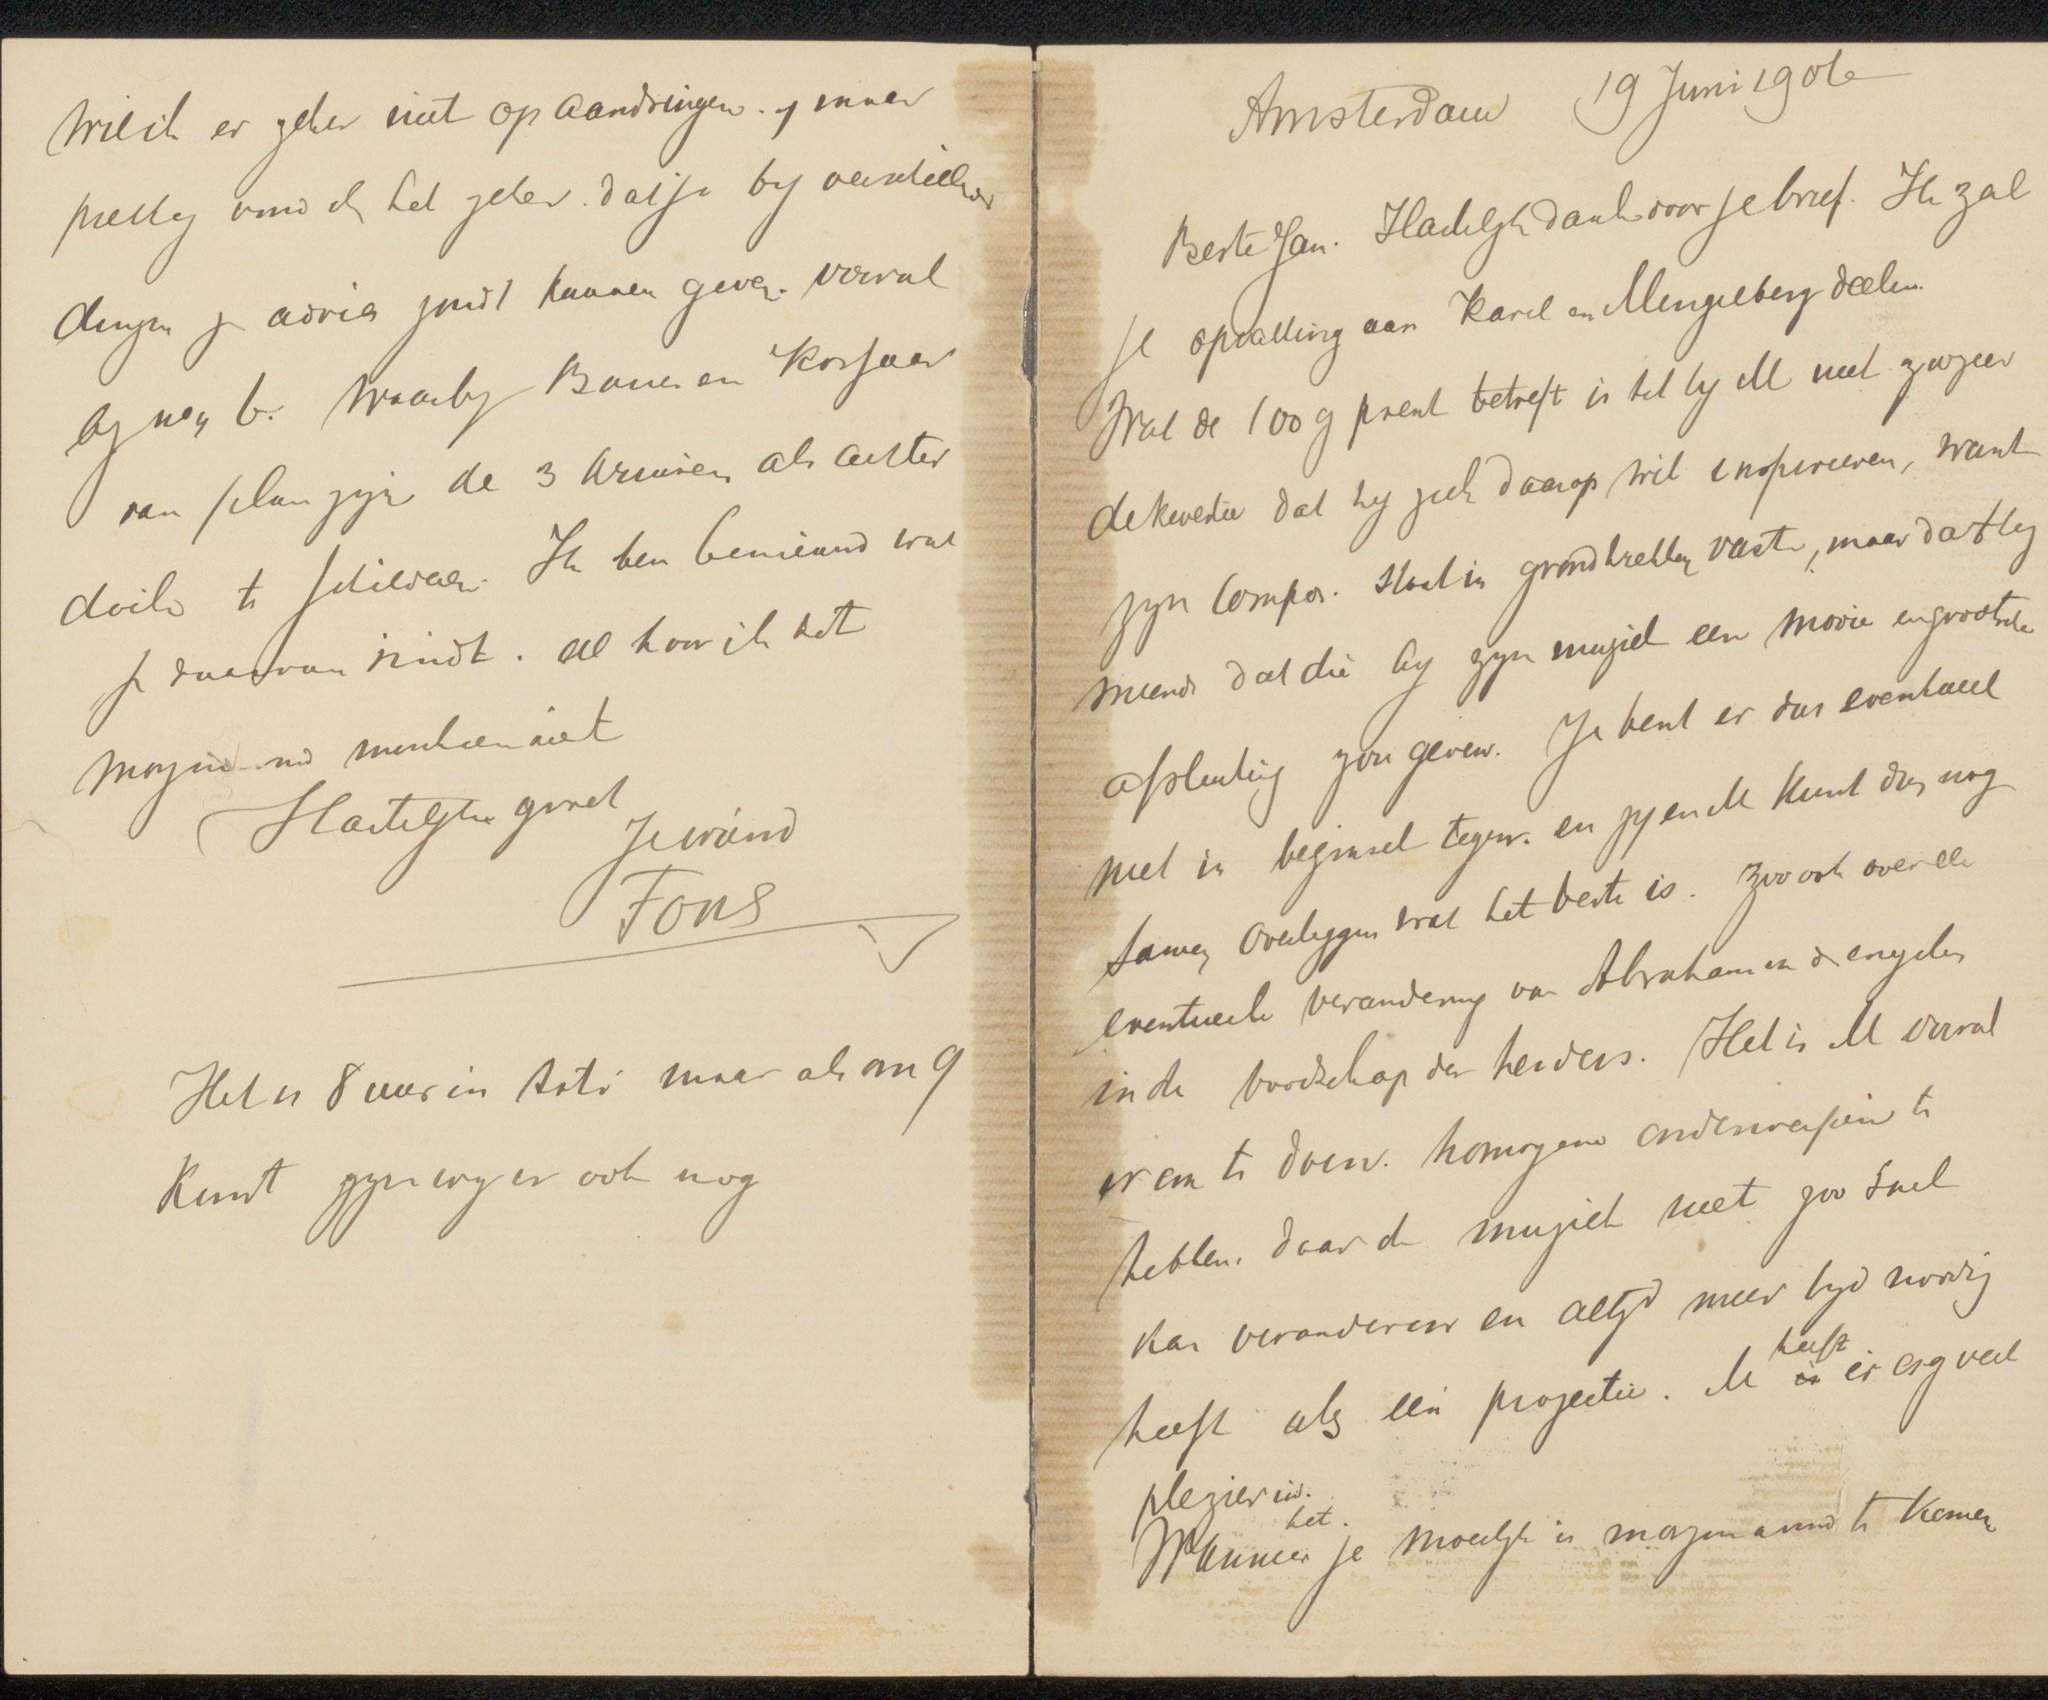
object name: letter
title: Brief aan Jan Veth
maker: alphons diepenbrock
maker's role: componist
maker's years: 1862-1921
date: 1906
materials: ink, paper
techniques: pen, writing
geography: amsterdam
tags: dordrecht, designer, jan veth, the hague, marius bauer, leiden, amsterdam, painter, print maker, draughtsman, rembrandt van rijn, lodewijk van deyssel, utrecht, music, the graphic arts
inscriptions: collector's mark: ‘RPK’